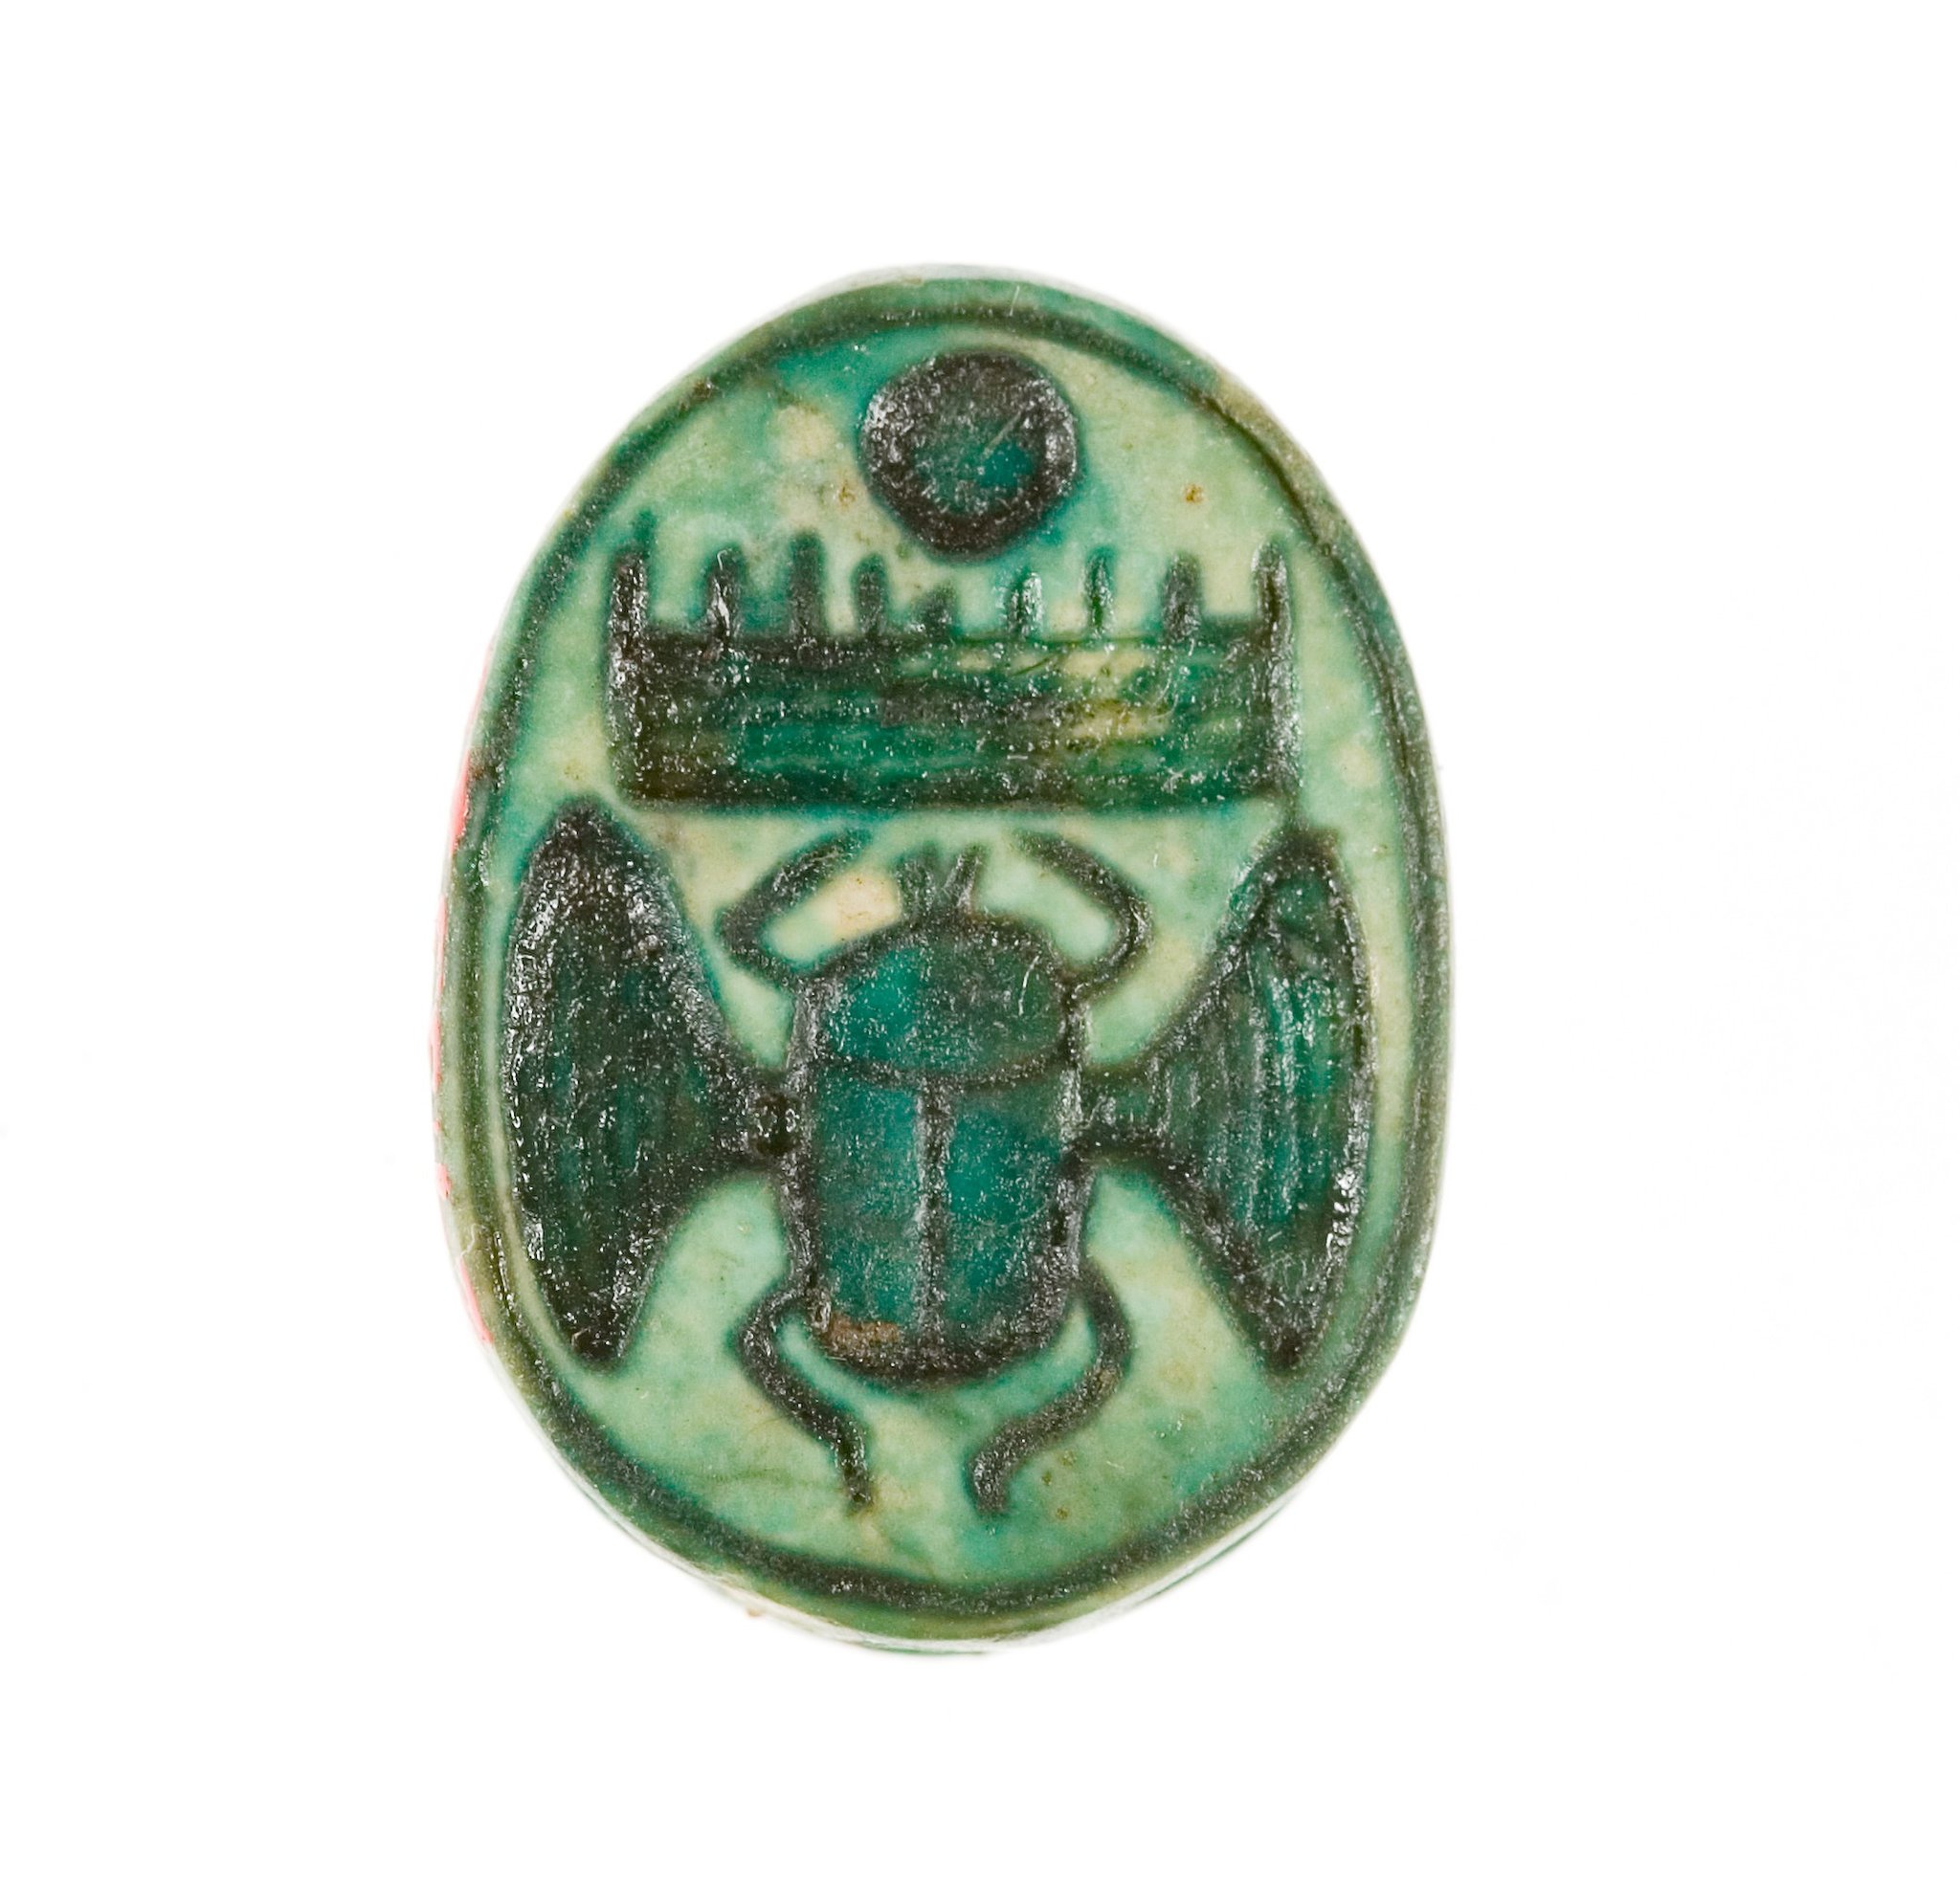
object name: scarab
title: Scarab Inscribed with the Throne Name of Thutmose III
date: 1479-1458 BCE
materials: stone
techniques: glazing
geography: egypt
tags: scarabs